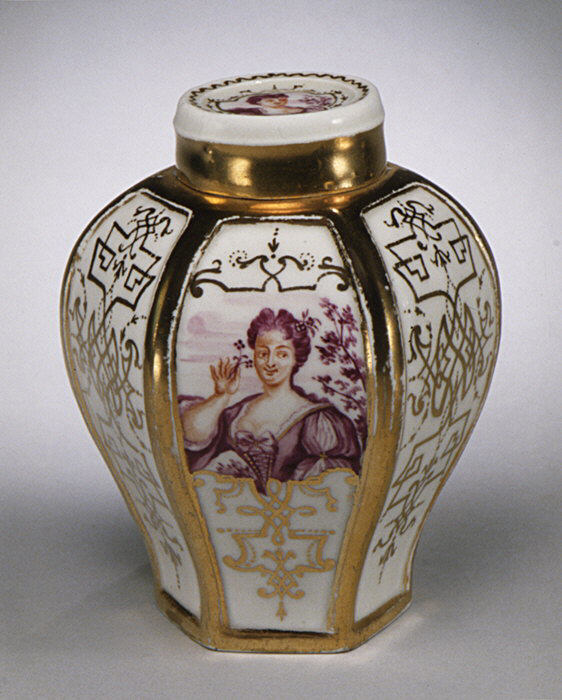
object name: caddy with cover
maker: abraham seuter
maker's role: decorator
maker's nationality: german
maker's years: 1689-1747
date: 1740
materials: hard paste porcelain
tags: portraits,women